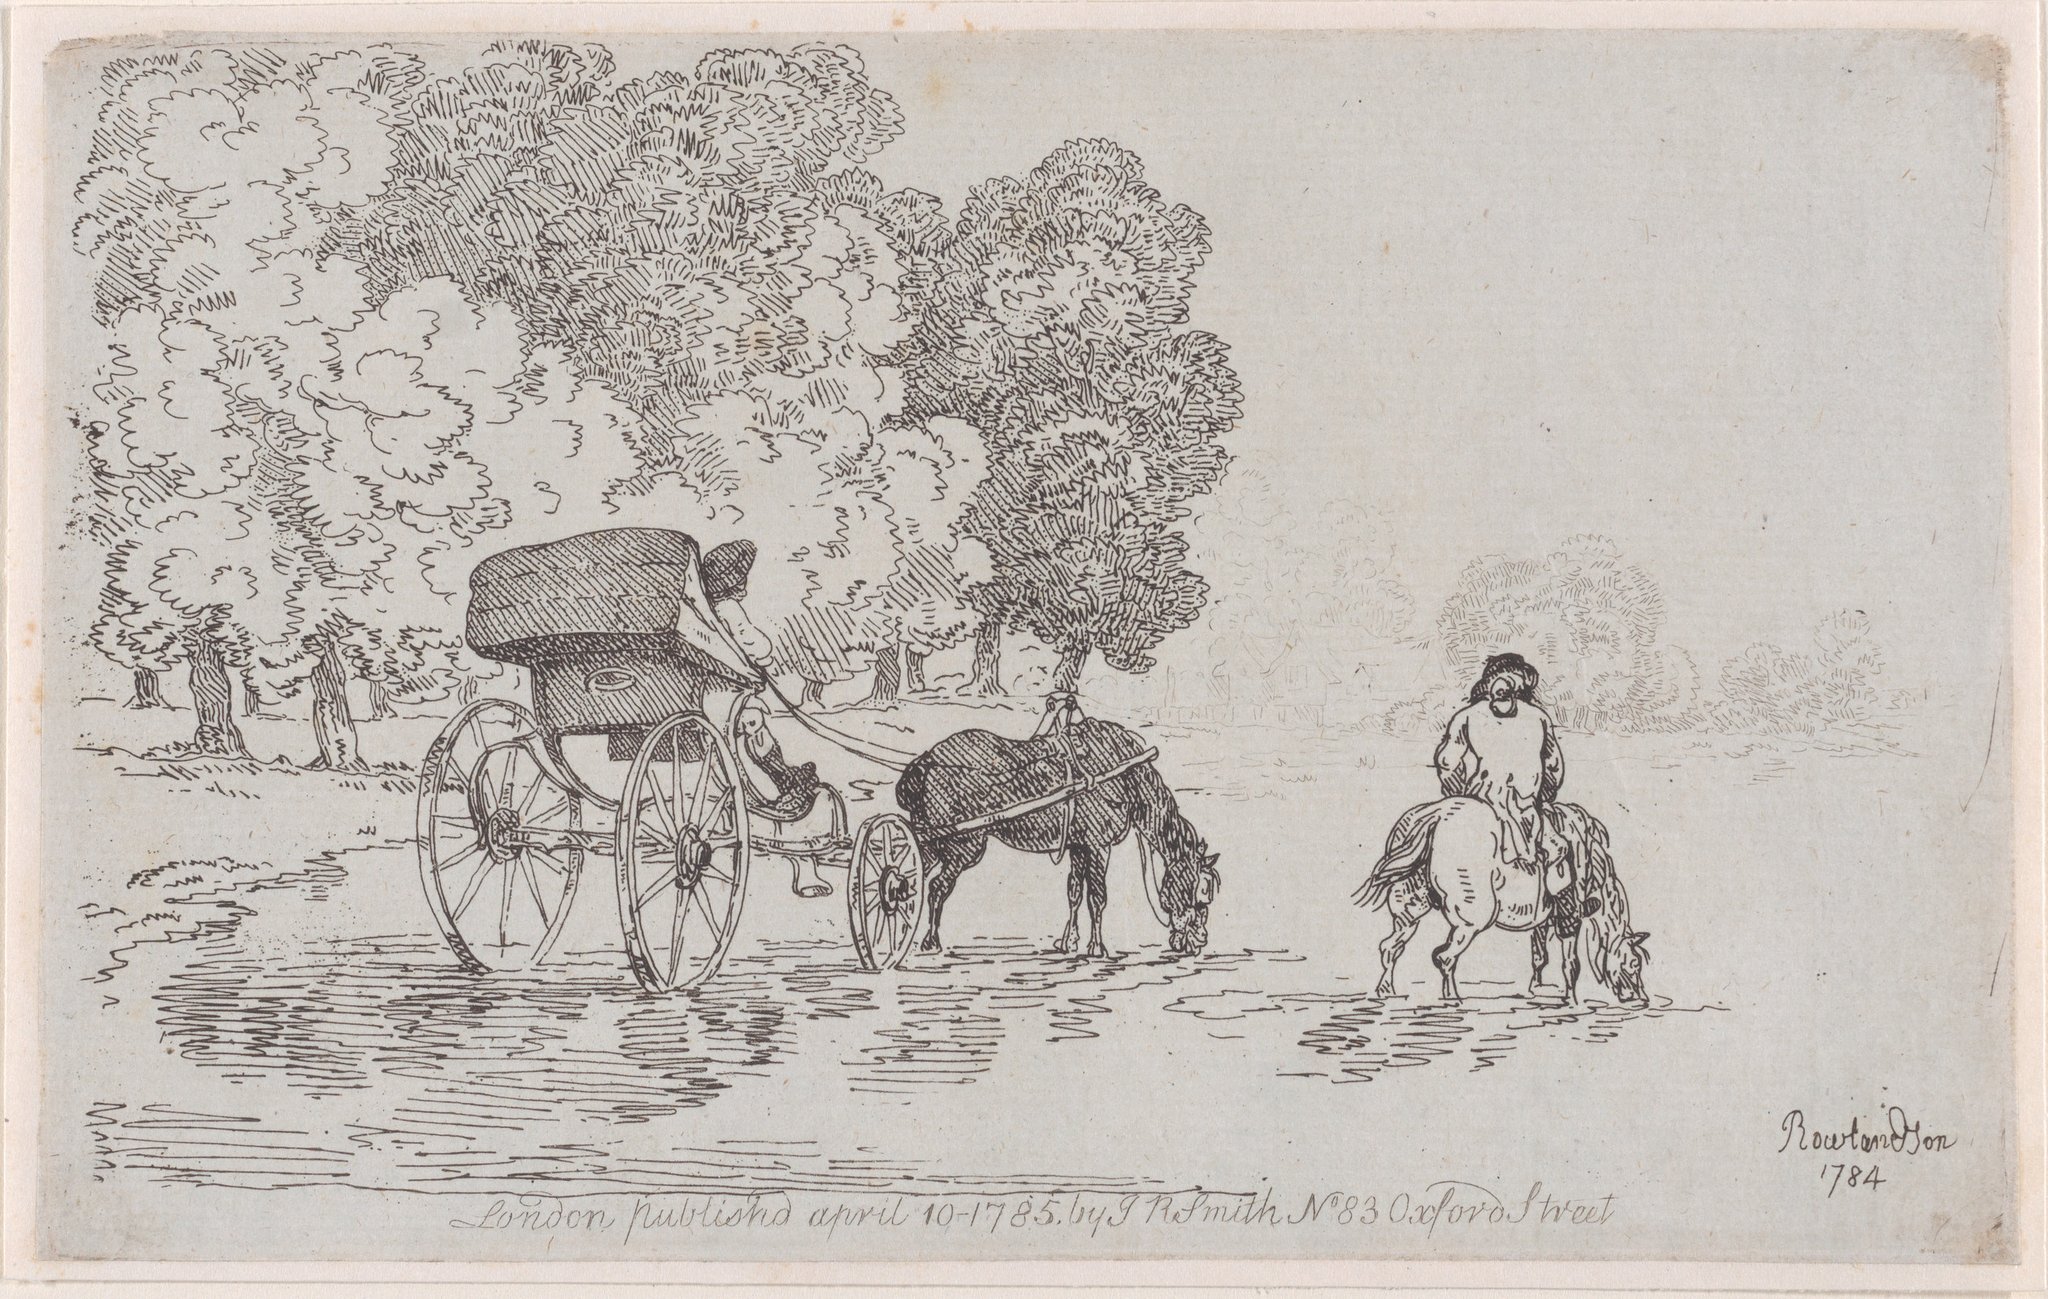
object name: print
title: Four Wheel Chaise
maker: thomas rowlandson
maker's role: artist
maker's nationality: british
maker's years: 1757-1827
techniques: etching, stippling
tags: horses,carriages